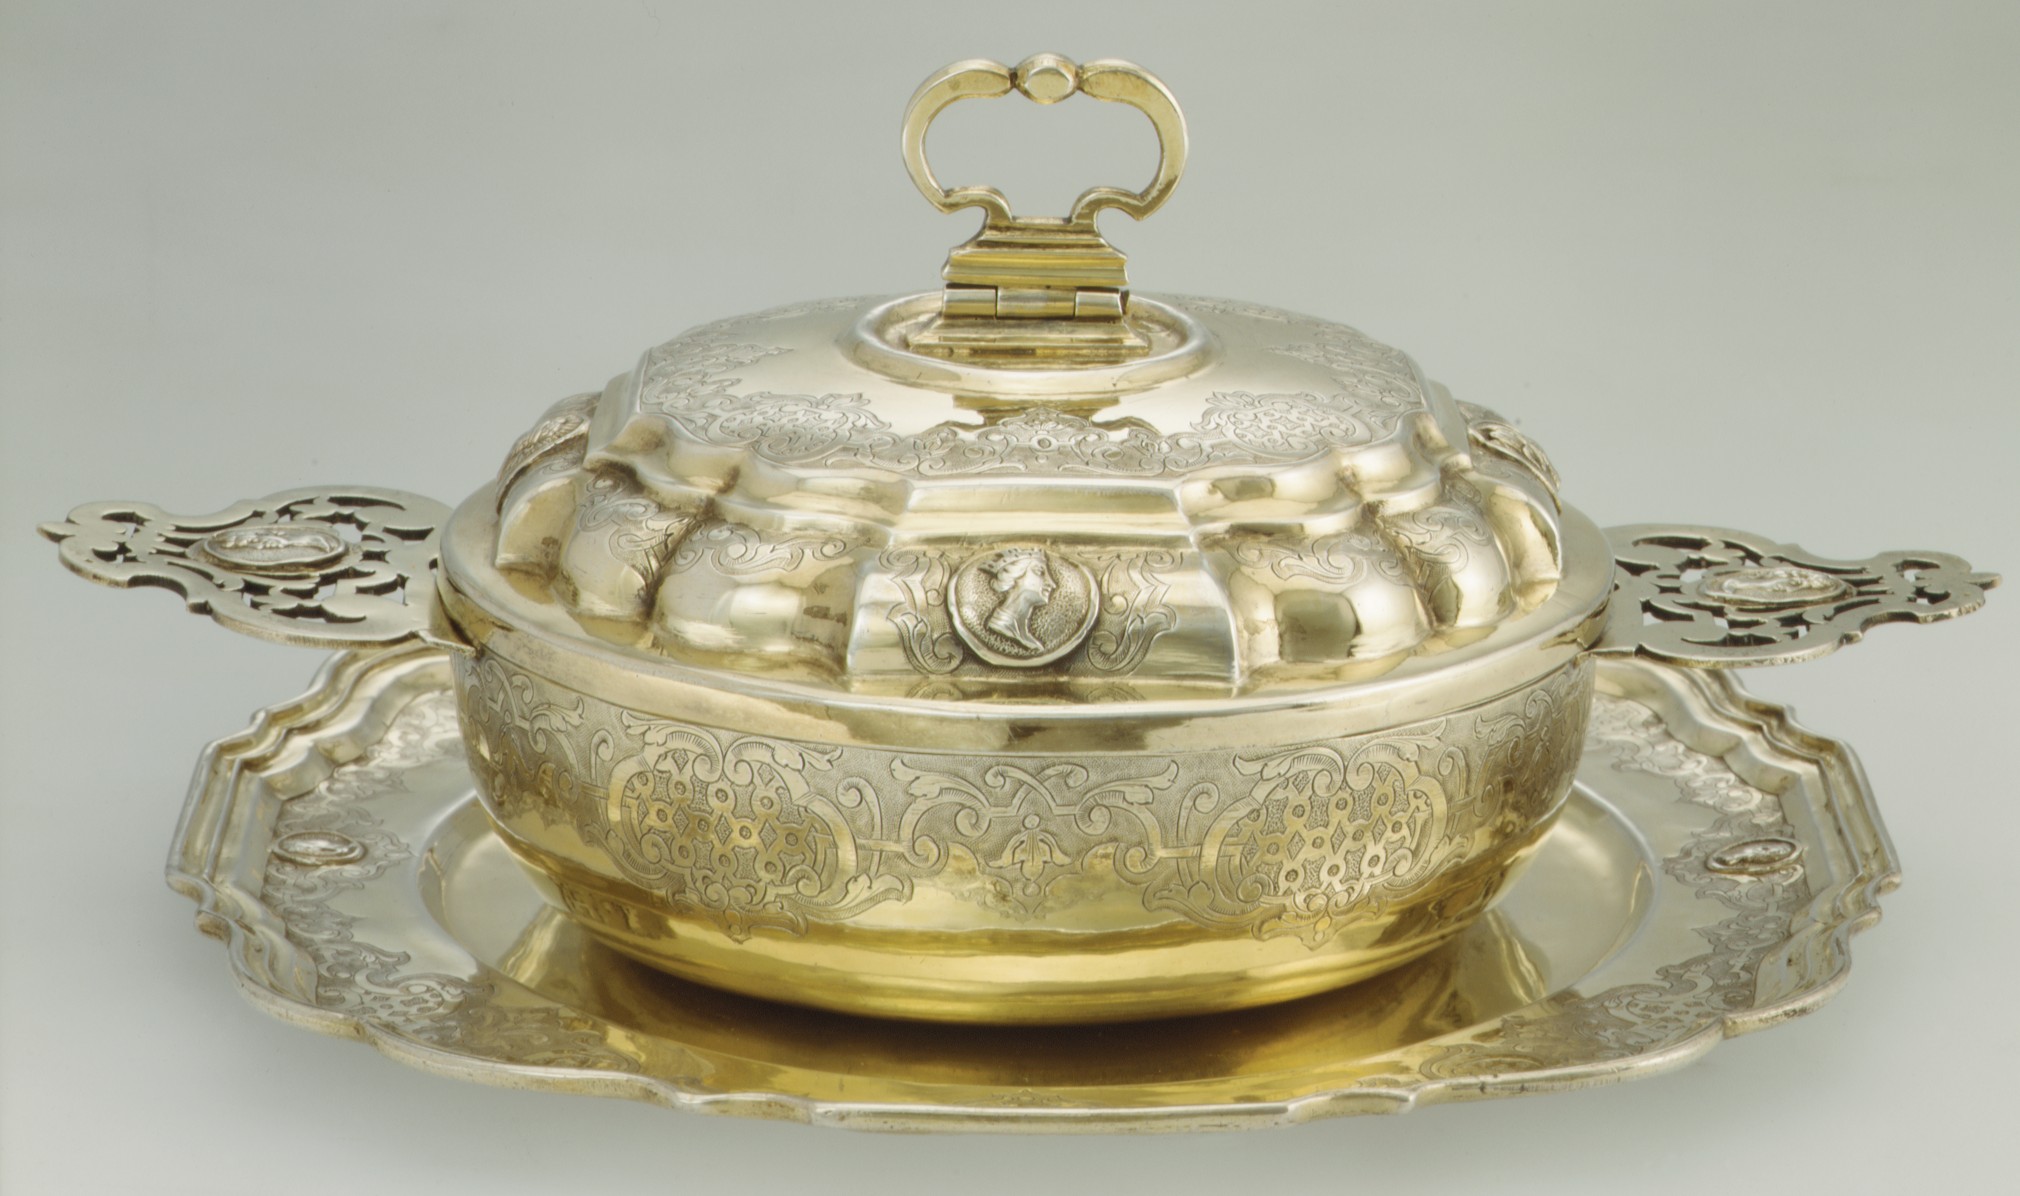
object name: bowl with cover and plate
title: Bowl with cover (écuelle) and plate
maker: ludwig schneider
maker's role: maker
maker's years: 1684-1729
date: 1713-1715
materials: silver gilt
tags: profiles